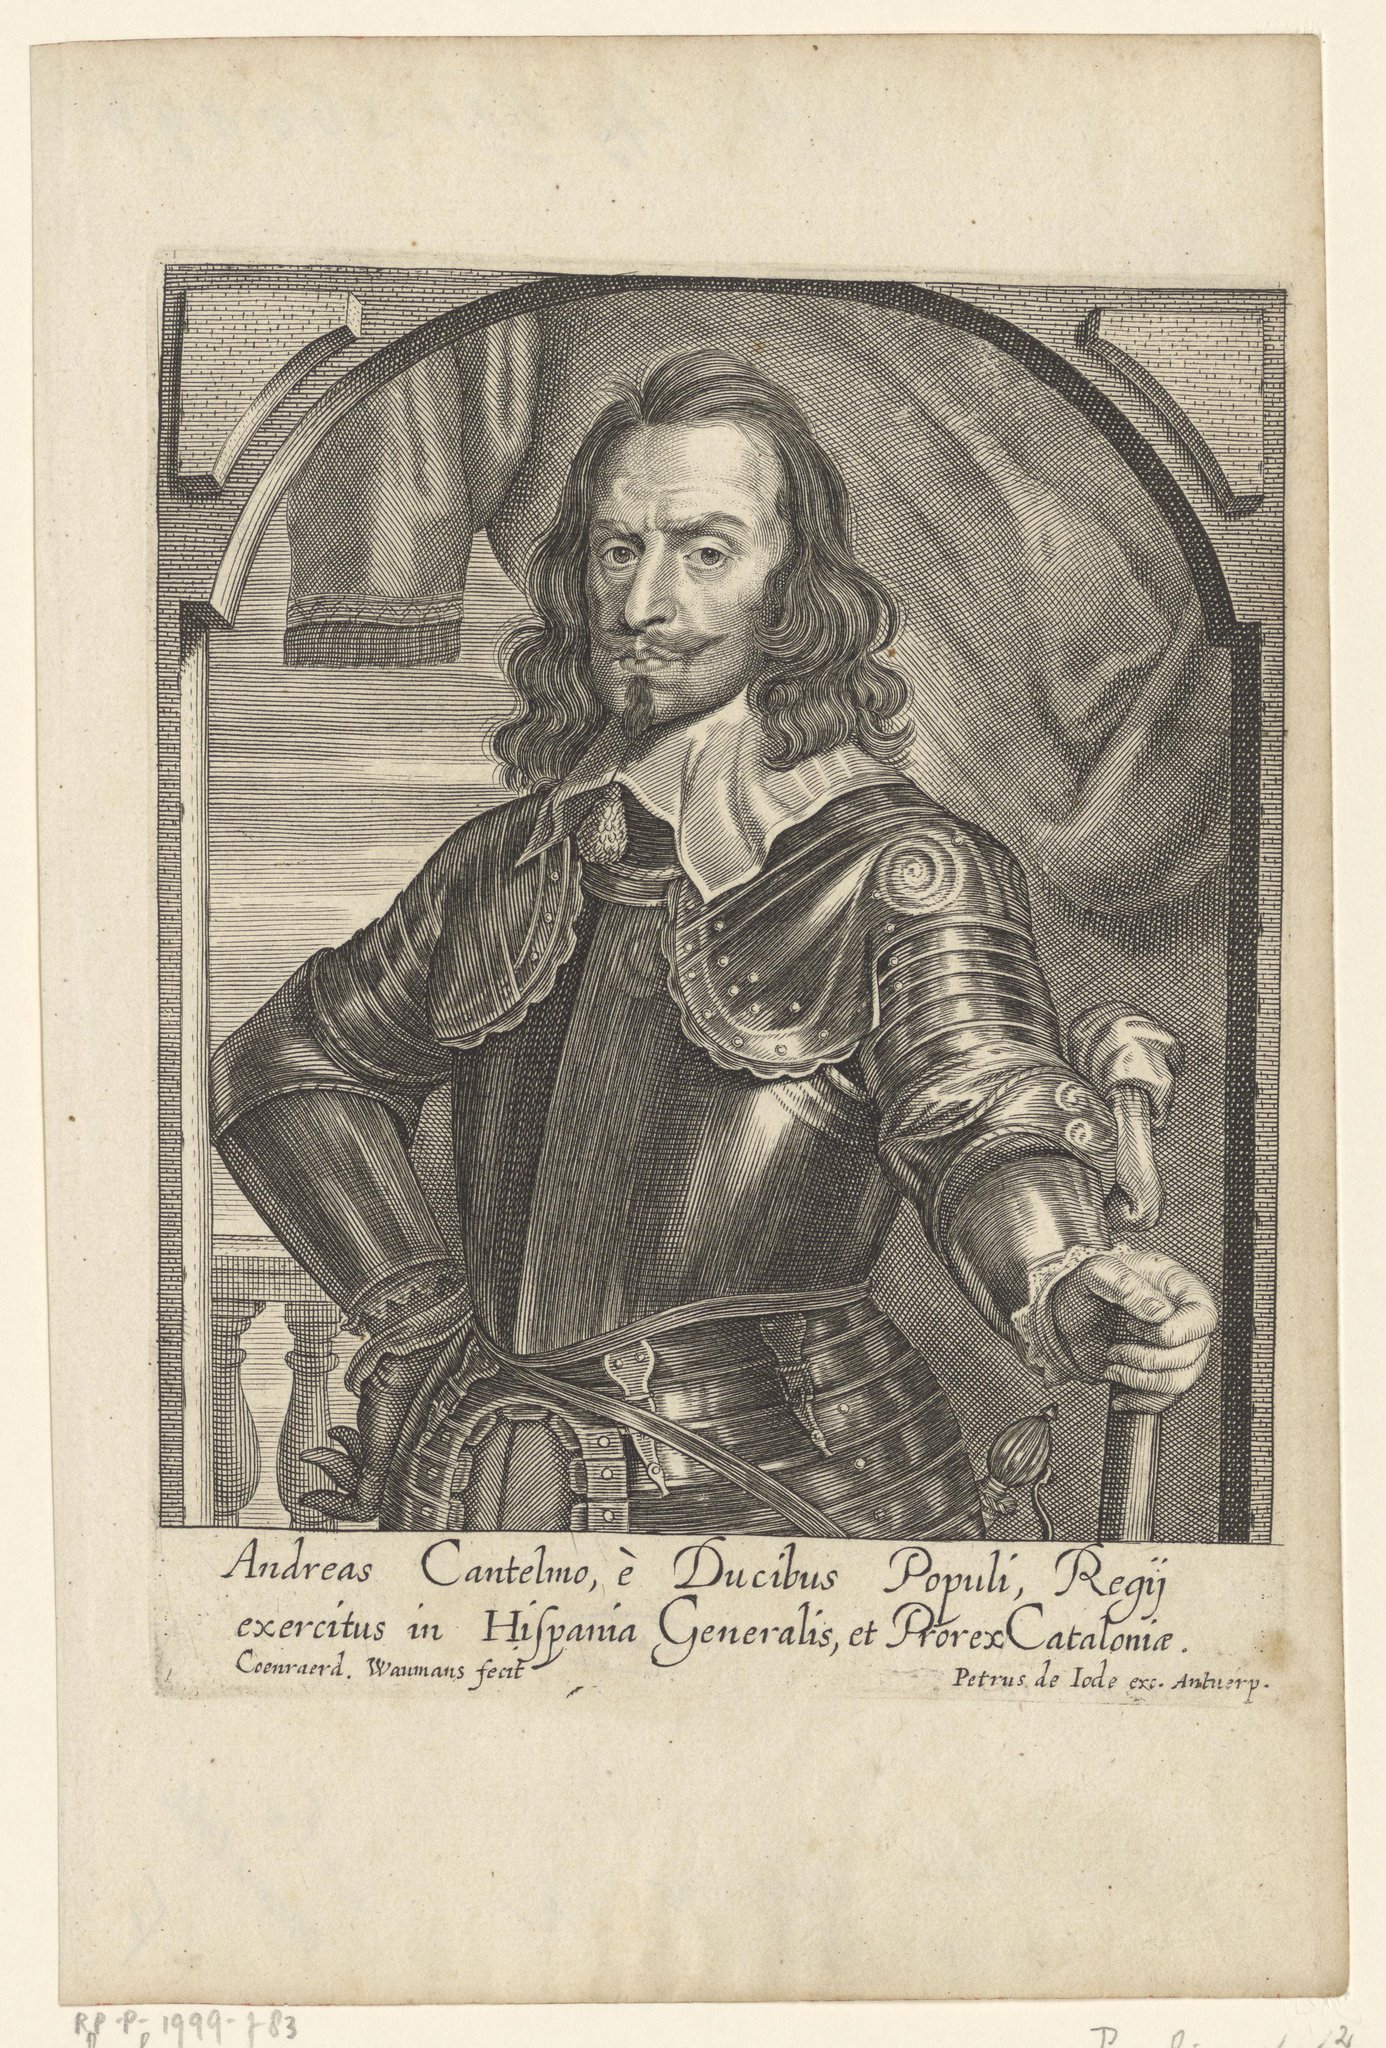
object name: print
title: Portret van Andreas de Cantelmo (1598-1645)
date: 1629-1674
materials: paper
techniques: engraving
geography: antwerp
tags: don andrea cantelmo, historical persons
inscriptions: collector's mark: Lugt 2228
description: Portret van Andreas de Cantelmo, bevelhebber van de Spaanse troepen, in een boogvormig venster, gekleed in een harnas.